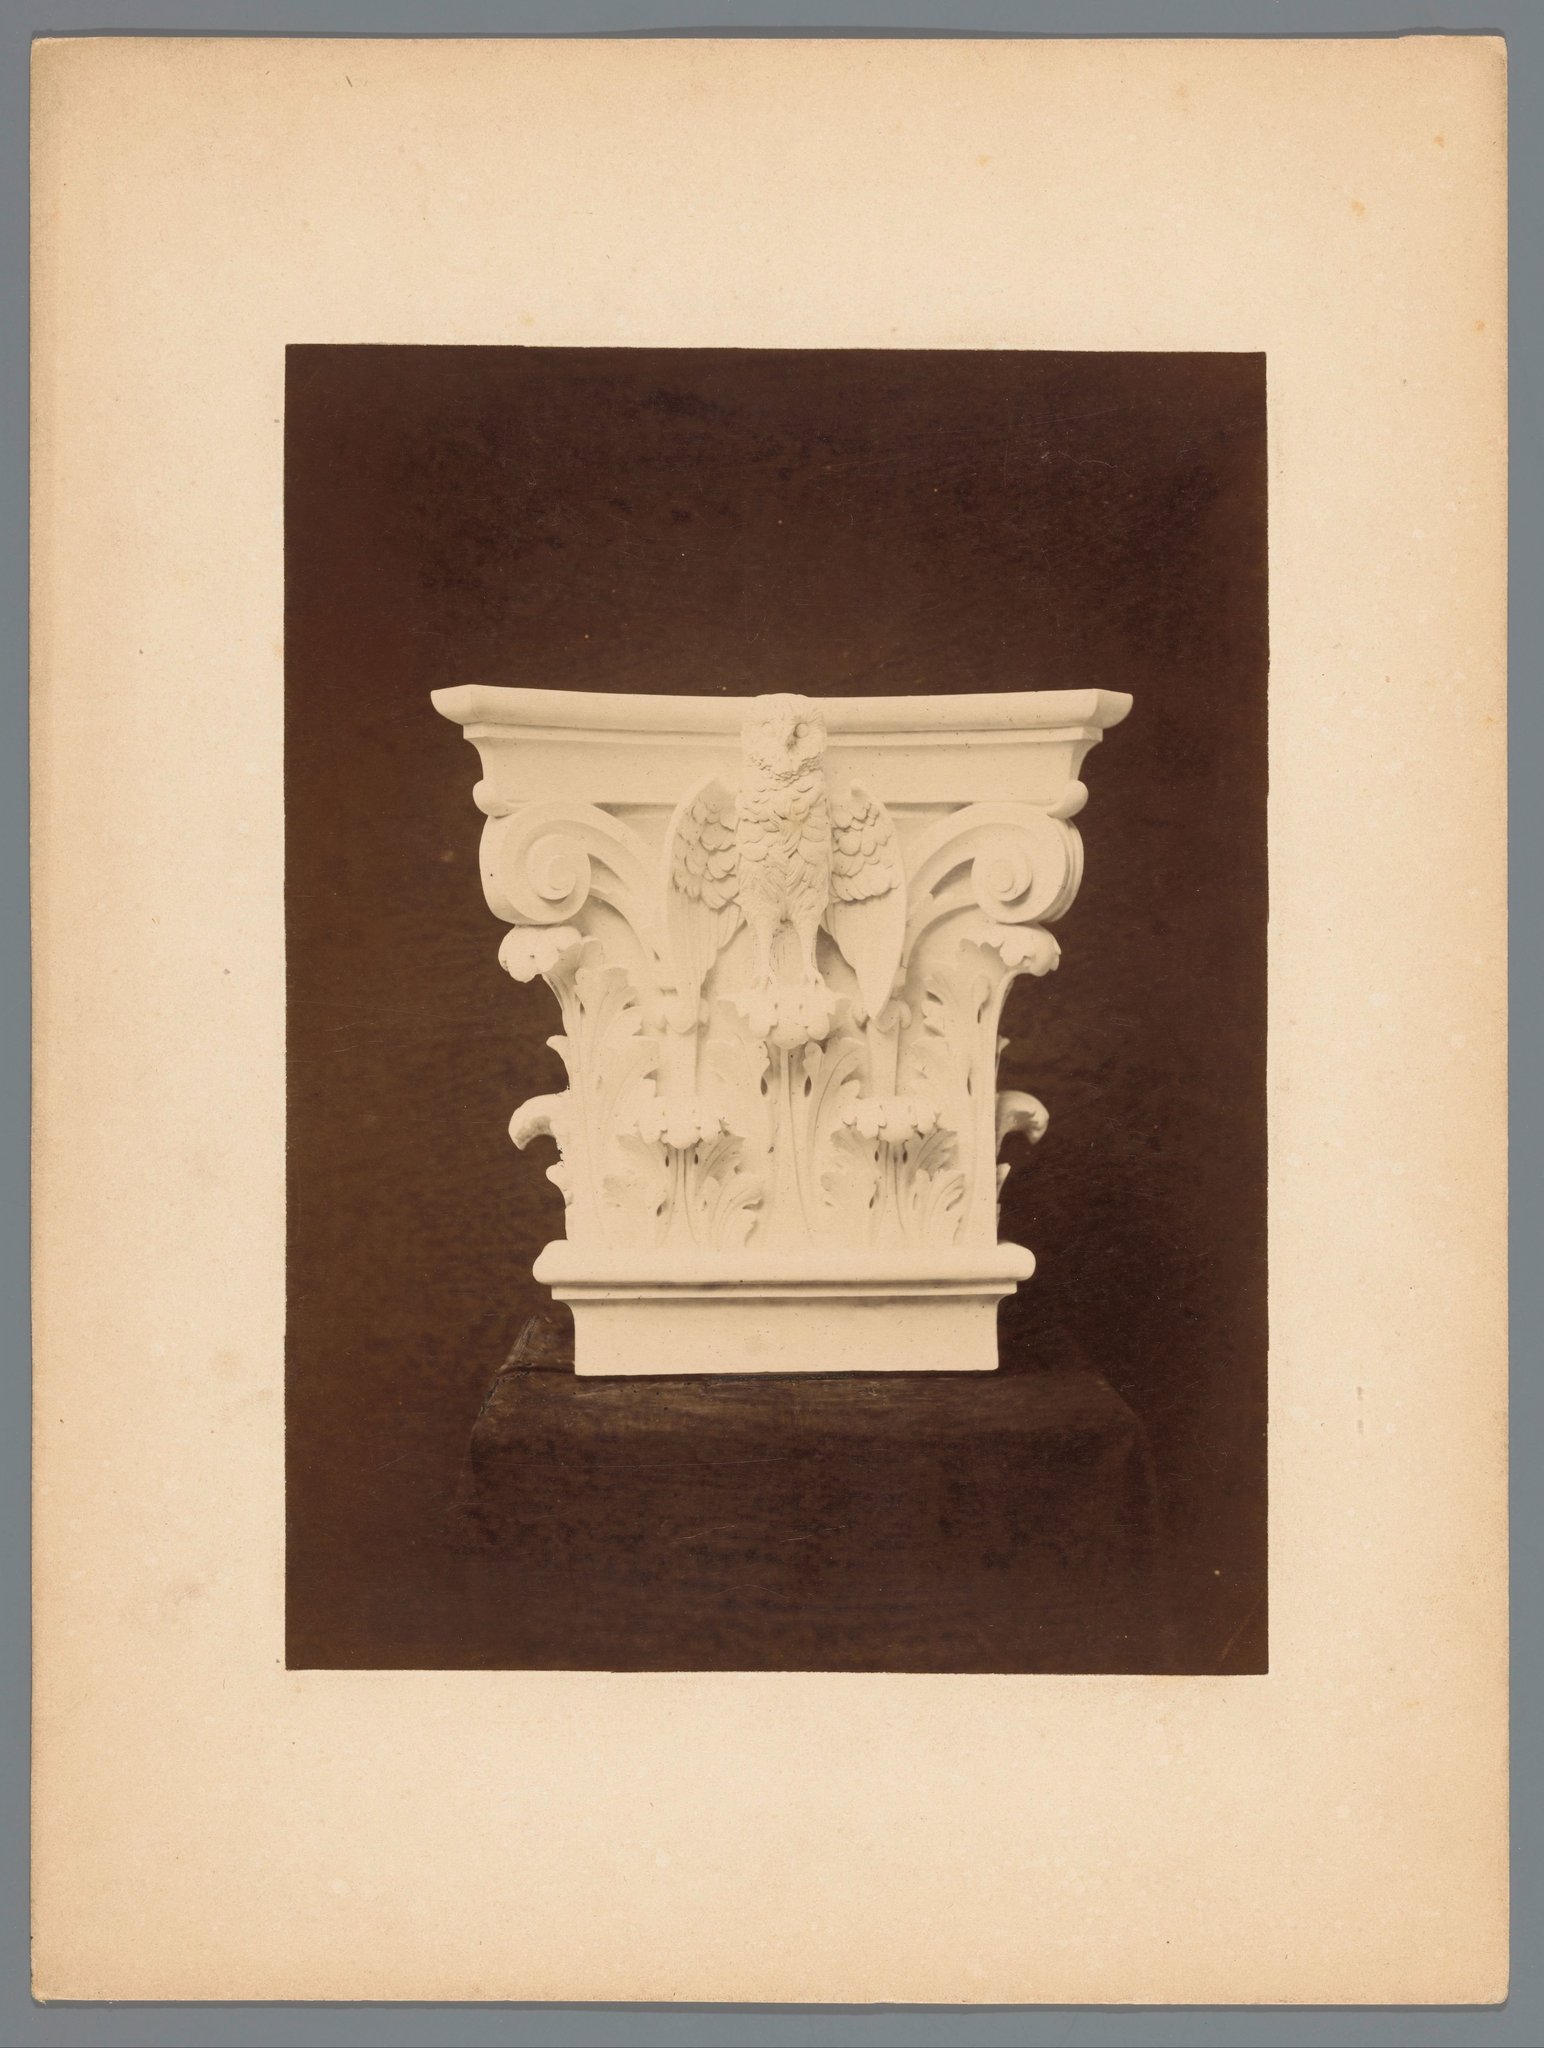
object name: photograph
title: Kapiteel met acanthusbladeren en een uil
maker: Anonymous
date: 1875-1900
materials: cardboard, photographic support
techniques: albumen print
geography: europe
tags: acanthus ~ ornament, owls, capital (~ column, pillar), europe